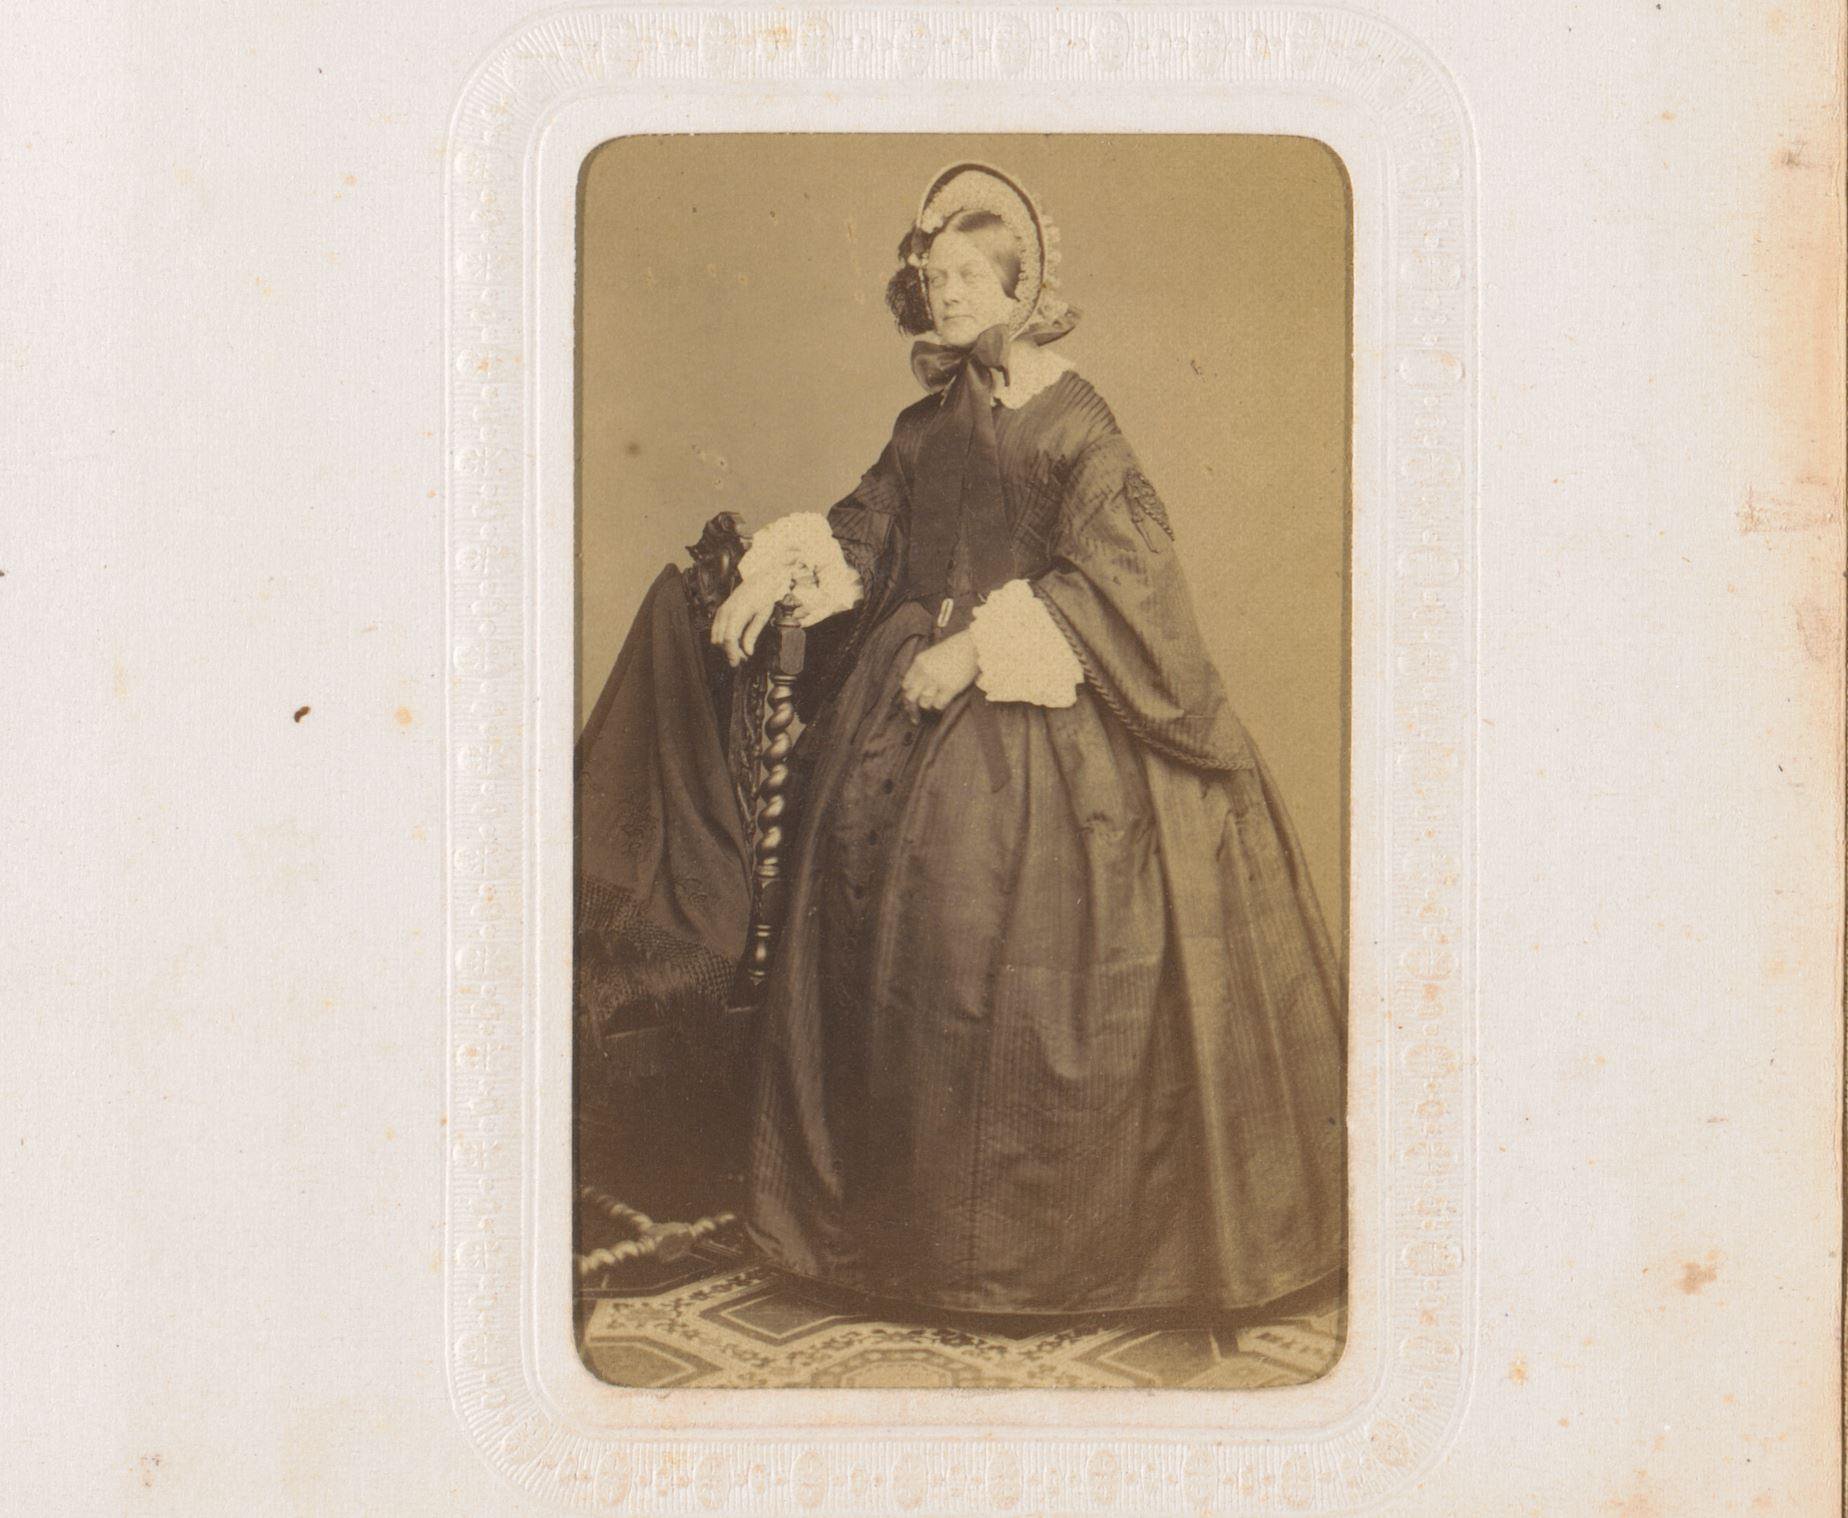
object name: carte de visite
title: Portret van een vrouw in zwarte jurk met hoed, staand bij een stoel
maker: Anonymous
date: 1860-1900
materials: cardboard, photographic support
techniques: albumen print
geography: netherlands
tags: historical persons - bb - woman, head-gear: hat, standing figure - aa - female human figure